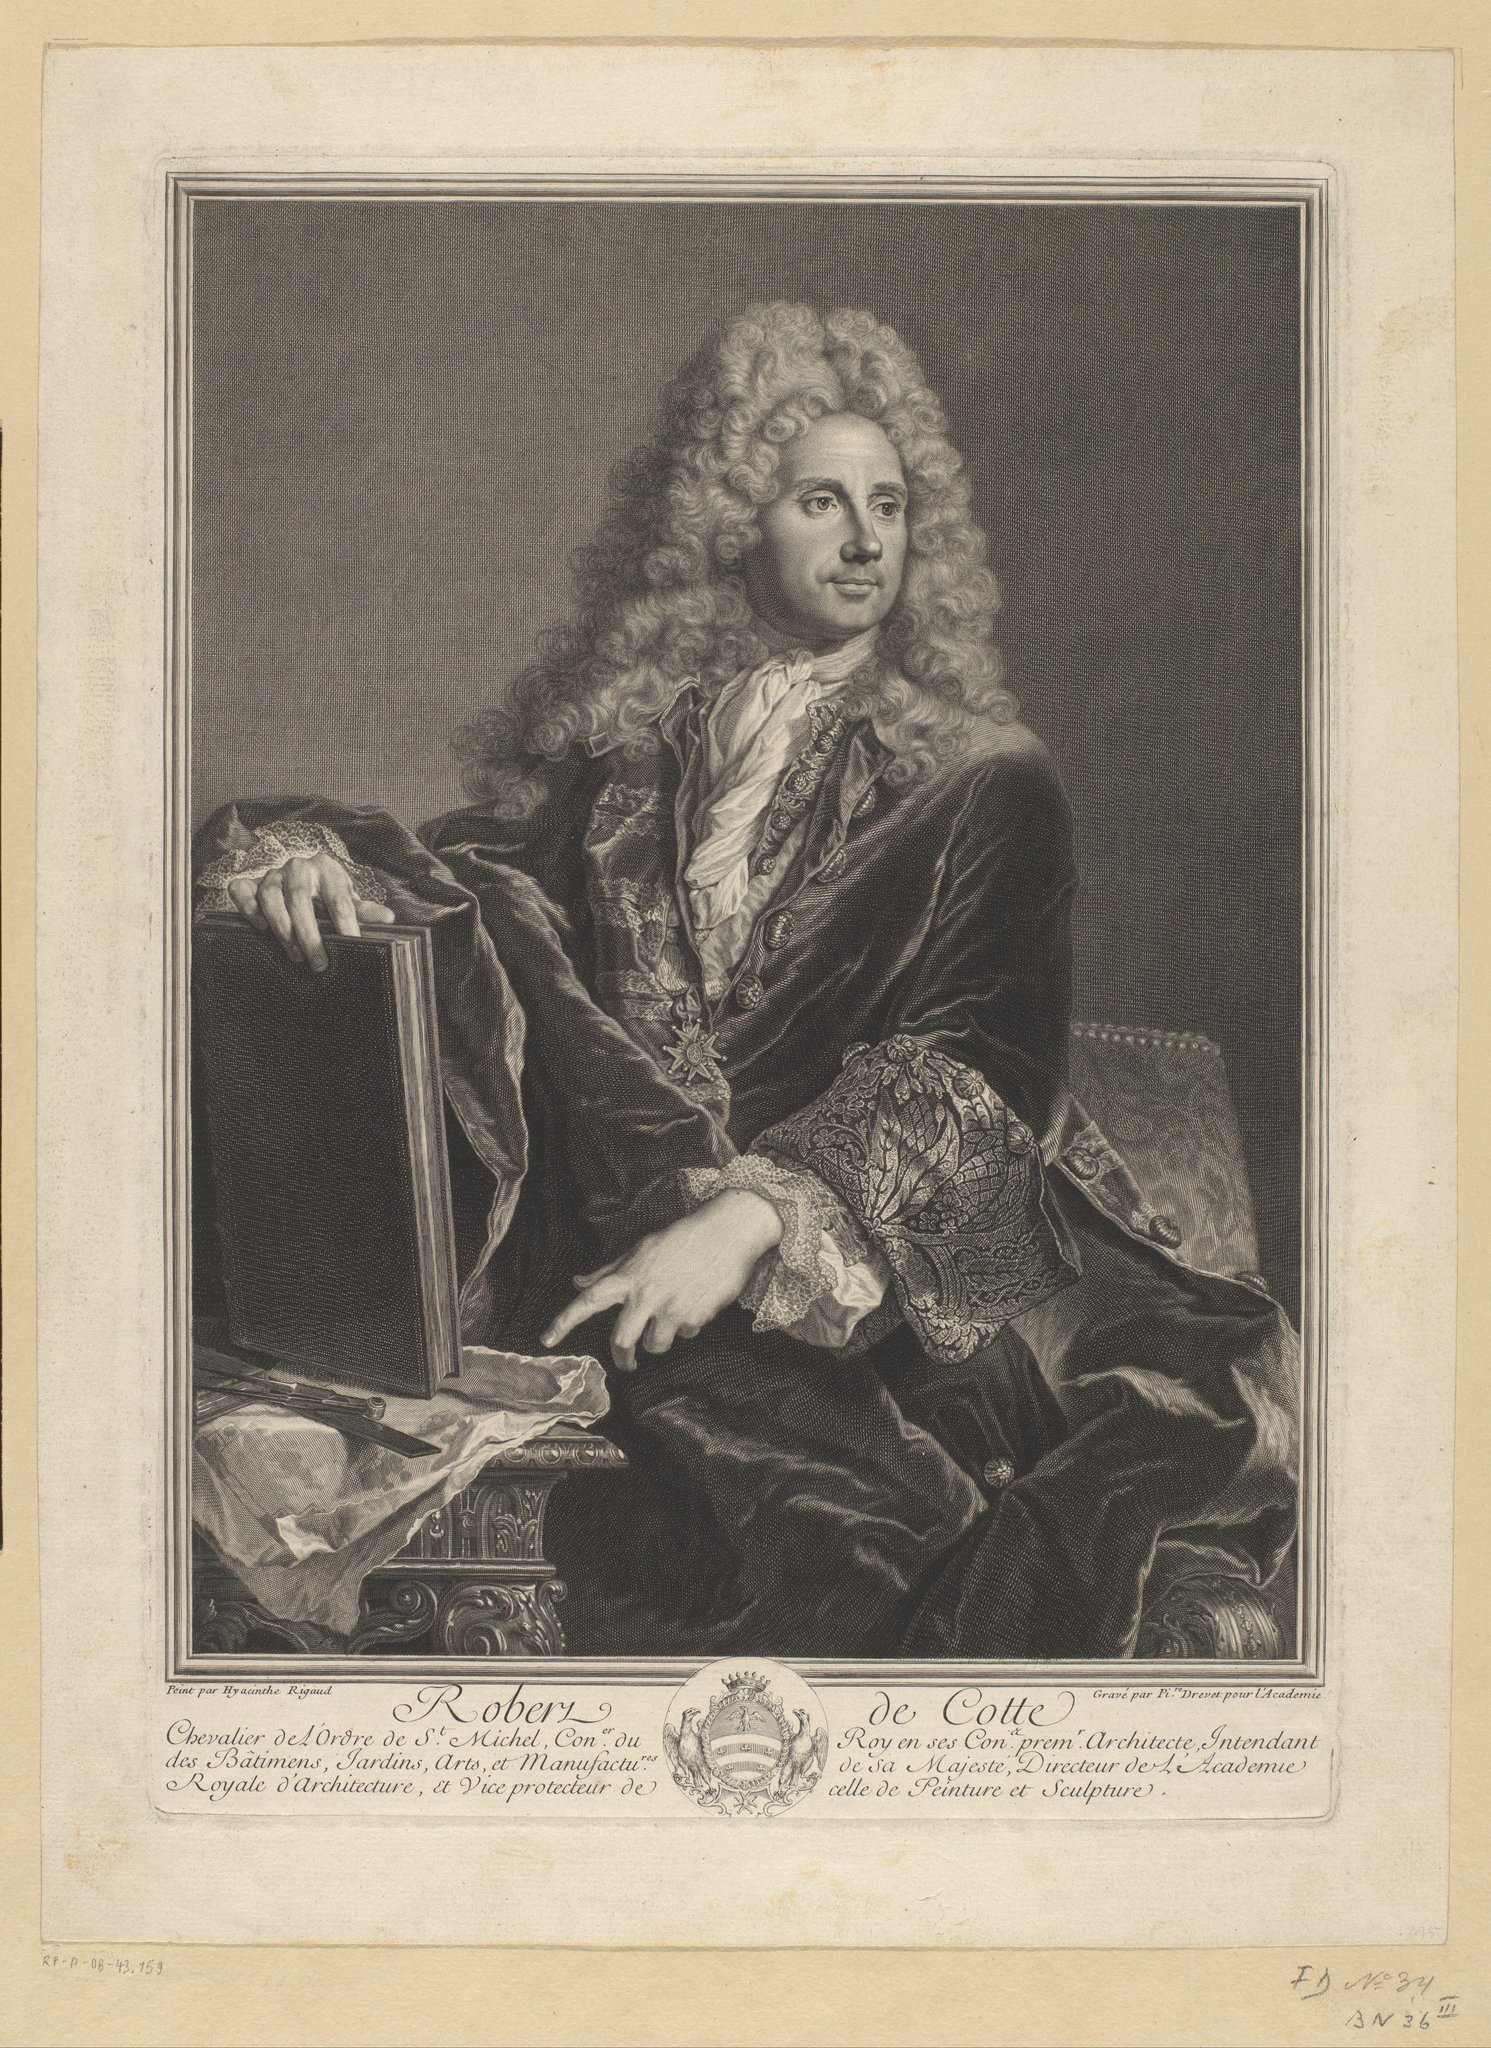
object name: print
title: Portret van Robert de Cotte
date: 1673-1738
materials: paper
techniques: engraving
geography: france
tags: paris, portrait, self-portrait of architect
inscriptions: collector's mark: Lugt 240